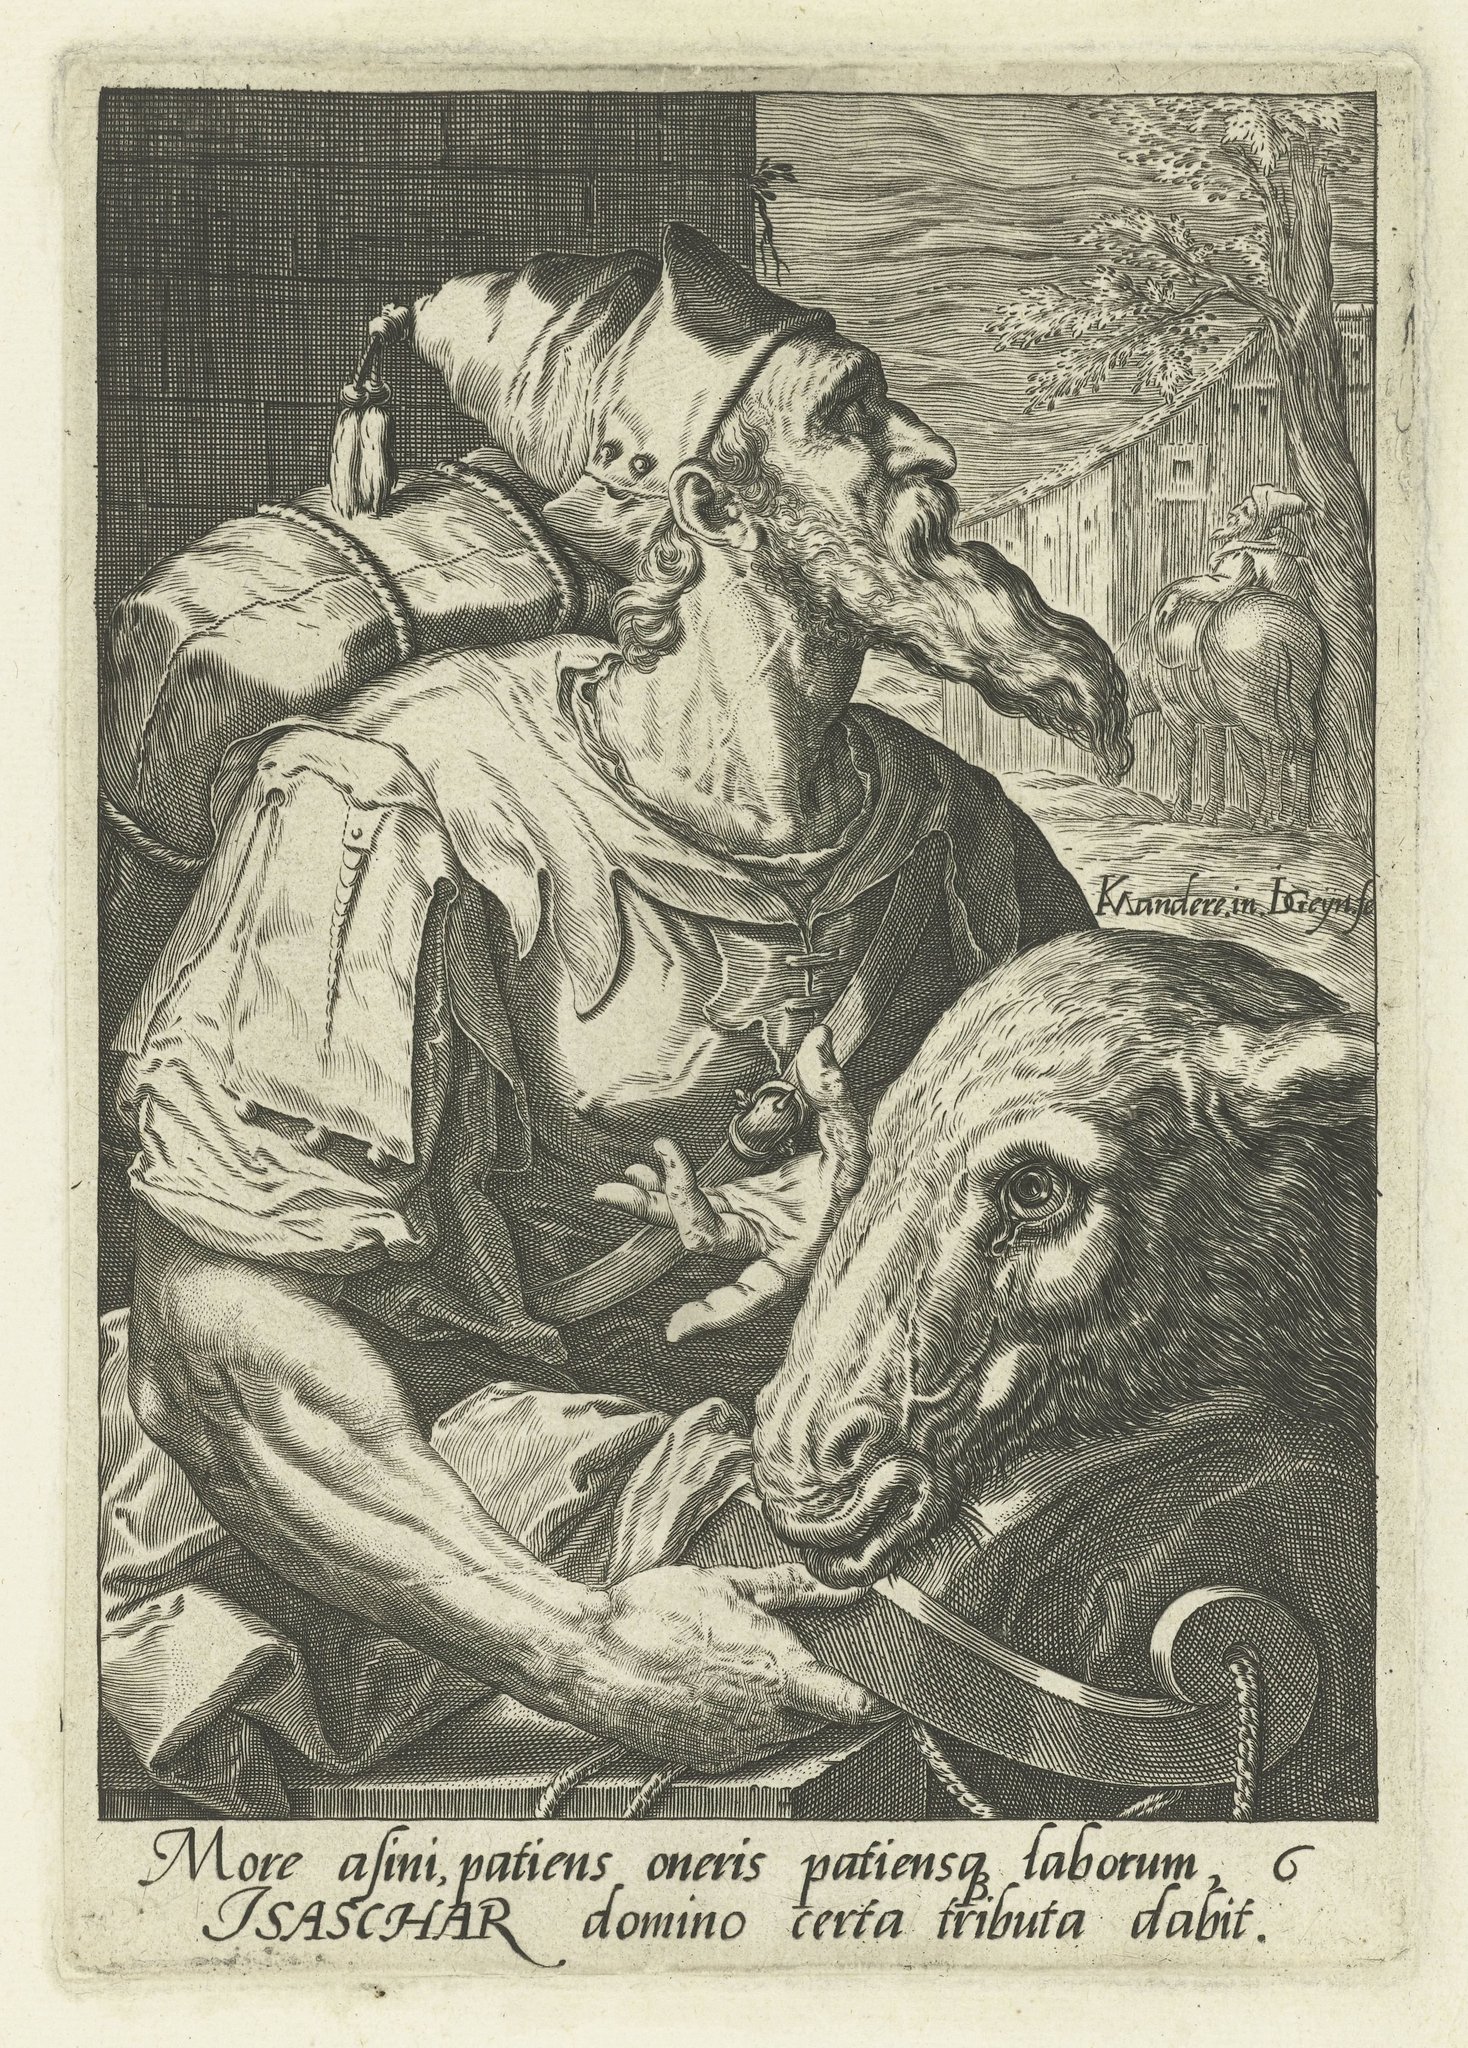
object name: print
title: Stamvader Issachar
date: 1587-1591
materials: paper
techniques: engraving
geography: netherlands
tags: the twelve patriarchs together, i.e. the twelve (grand)sons of jacob, eponymous ancestors of the twelve tribes of israel, the twelve tribes of israel (with name) (not in biblical context), male persons from the old testament (with name) (not in biblical context)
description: Stamvader Issachar, ten halven lijve, in de rechterhand een juk, aan zijn linkerzijde de kop van een ezel (verwijzingen naar Issachar als een 'sterke ezel' die 'zijn last droeg'). Op de achtergrond een huis of stal, een boom en een man bij een paard. Onder de voorstelling twee regels tekst in Latijn. Deze prent is onderdeel van een serie van twaalf stamvaders van |sraël; elke prent in deze serie bestaat uit een beeltenis van een stamvader, ten halven lijve, en een tweeregelig onderschrift in Latijn.